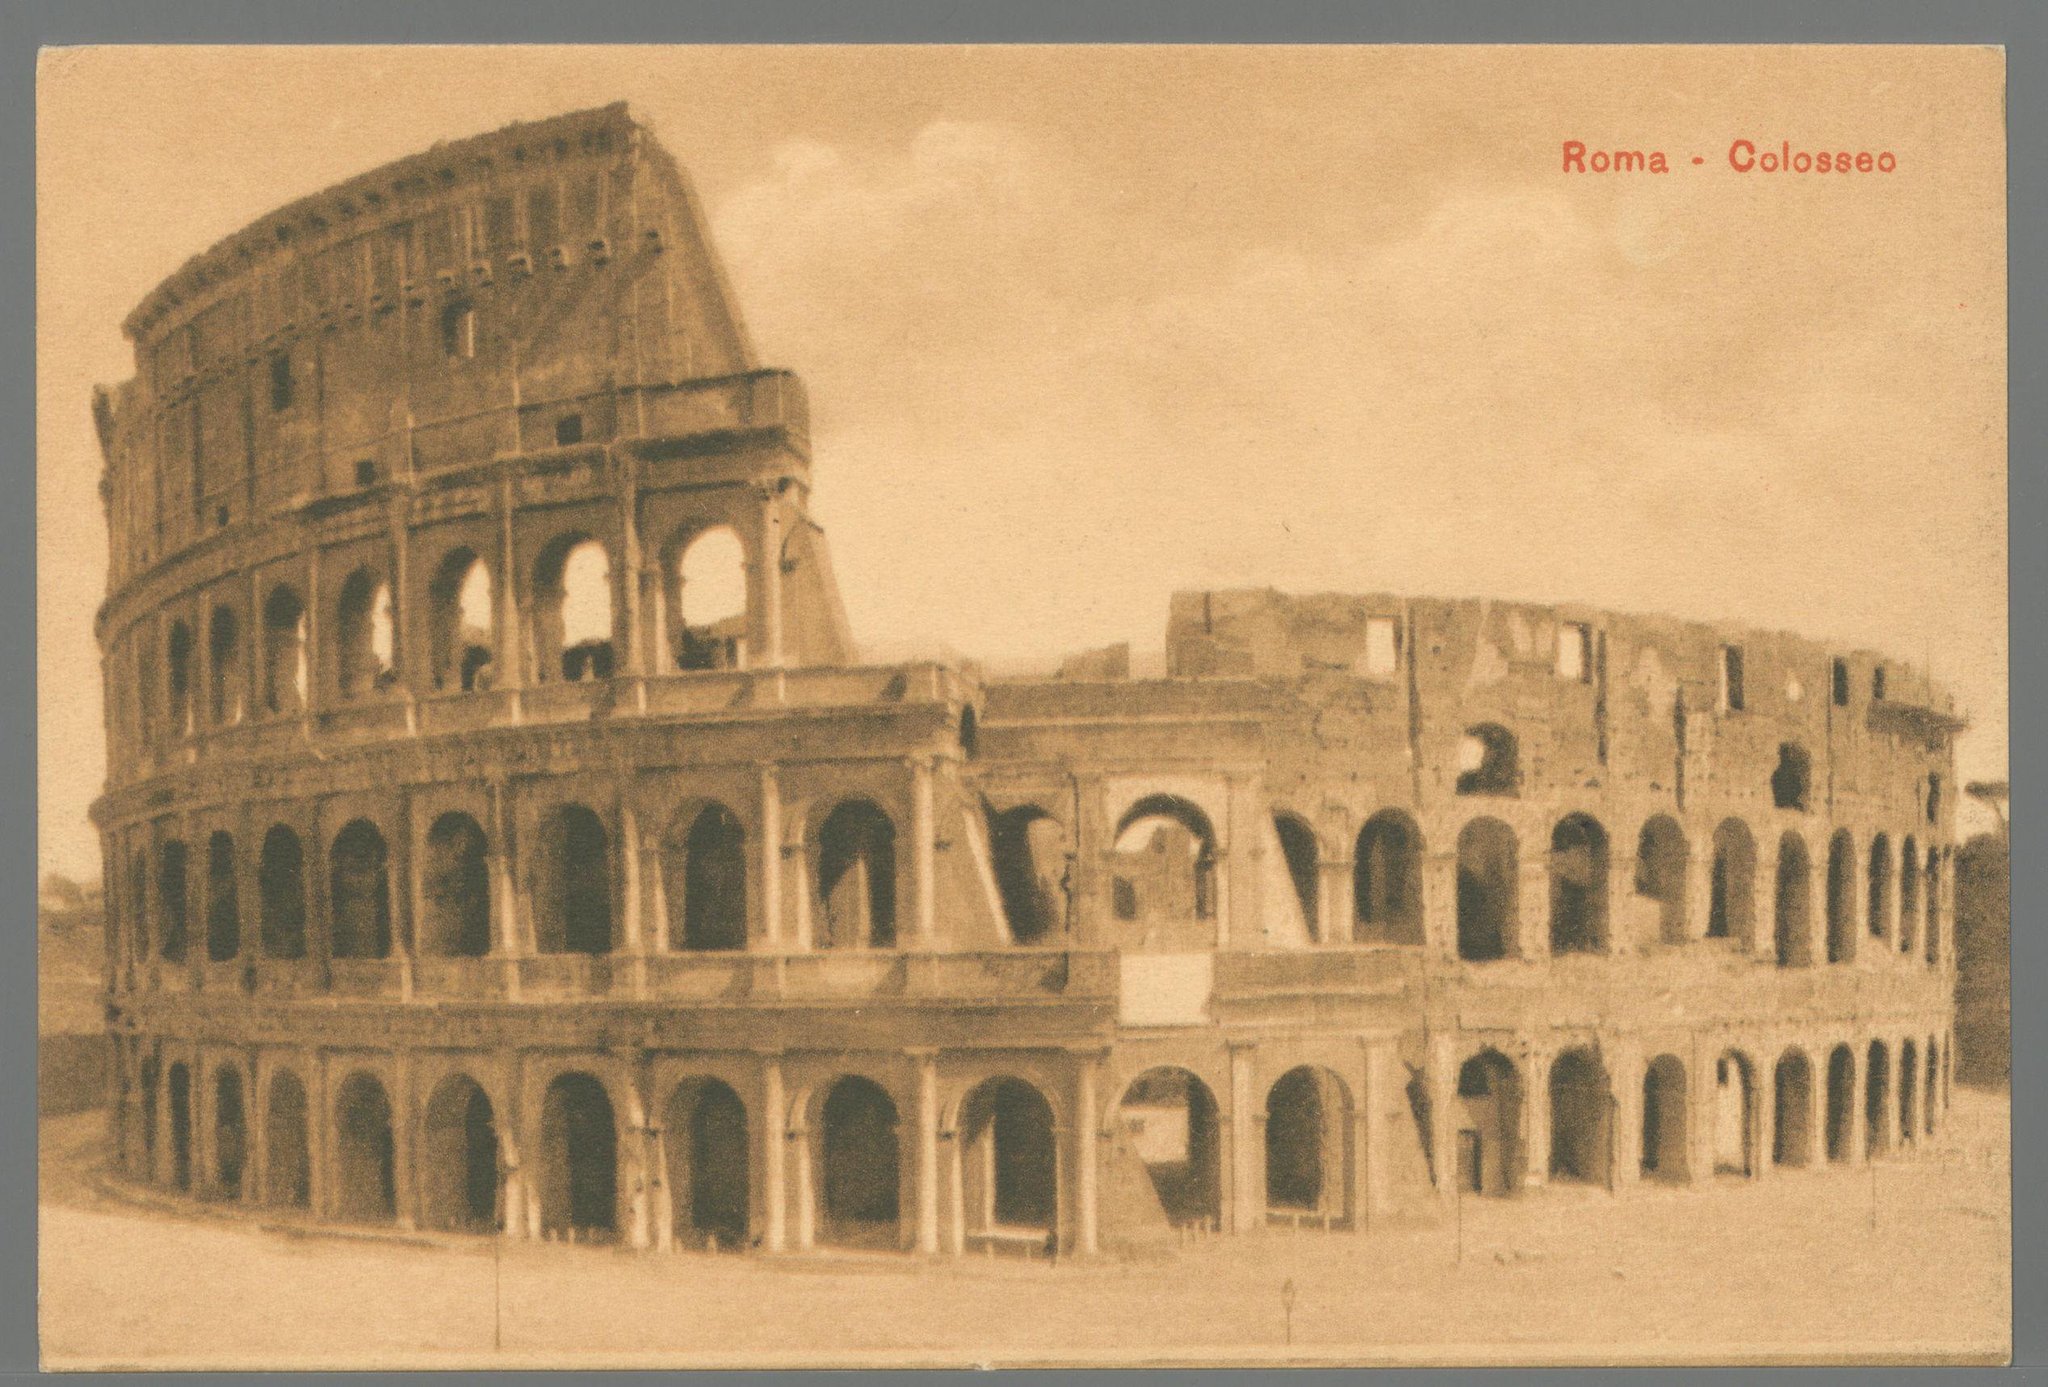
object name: ansichtkaart, prentbriefkaart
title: Roma. Colosseo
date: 1906-1920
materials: cardboard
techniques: photograph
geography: rome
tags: amphitheatre